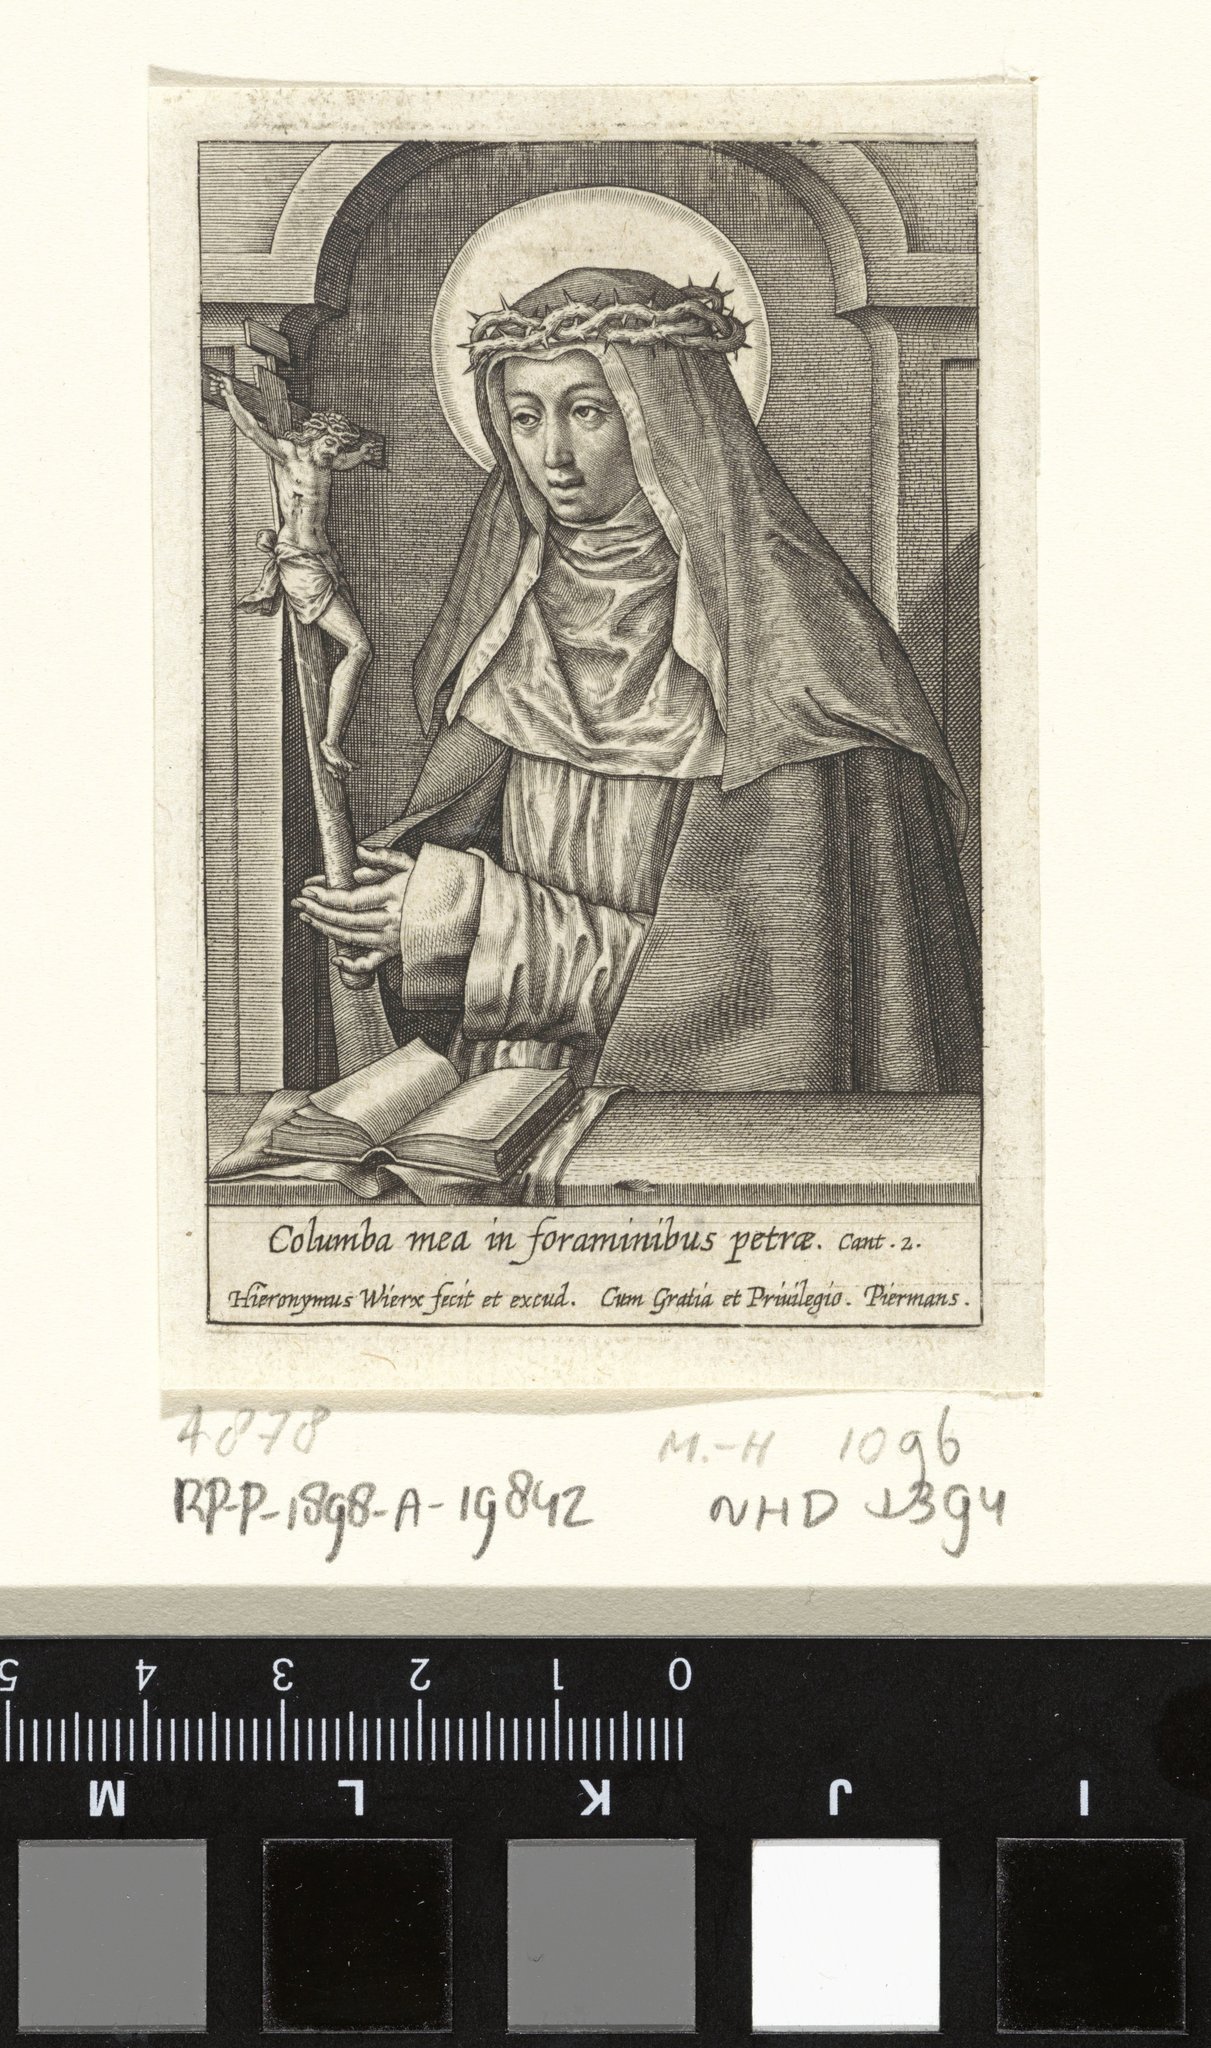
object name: print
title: H. Catharina van Siena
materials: paper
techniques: engraving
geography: antwerp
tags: the virgin and dominican tertiary, catherine of siena; possible attributes: book, cross, crown of thorns, crucifix, demon under foot, heart (with cross), lily, plague-stricken, ring, rosary, stigmata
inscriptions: collector's mark: Lugt 2228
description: De heilige Catharina van Siena in gebed voor een cruxifix. Ze draagt de tunica met sluier en een mantel van de derde dominicaner orde. Op haar hoofd de doornenkroon. In de marge een Bijbelcitaat uit Hoogl. 2 in het Latijn.